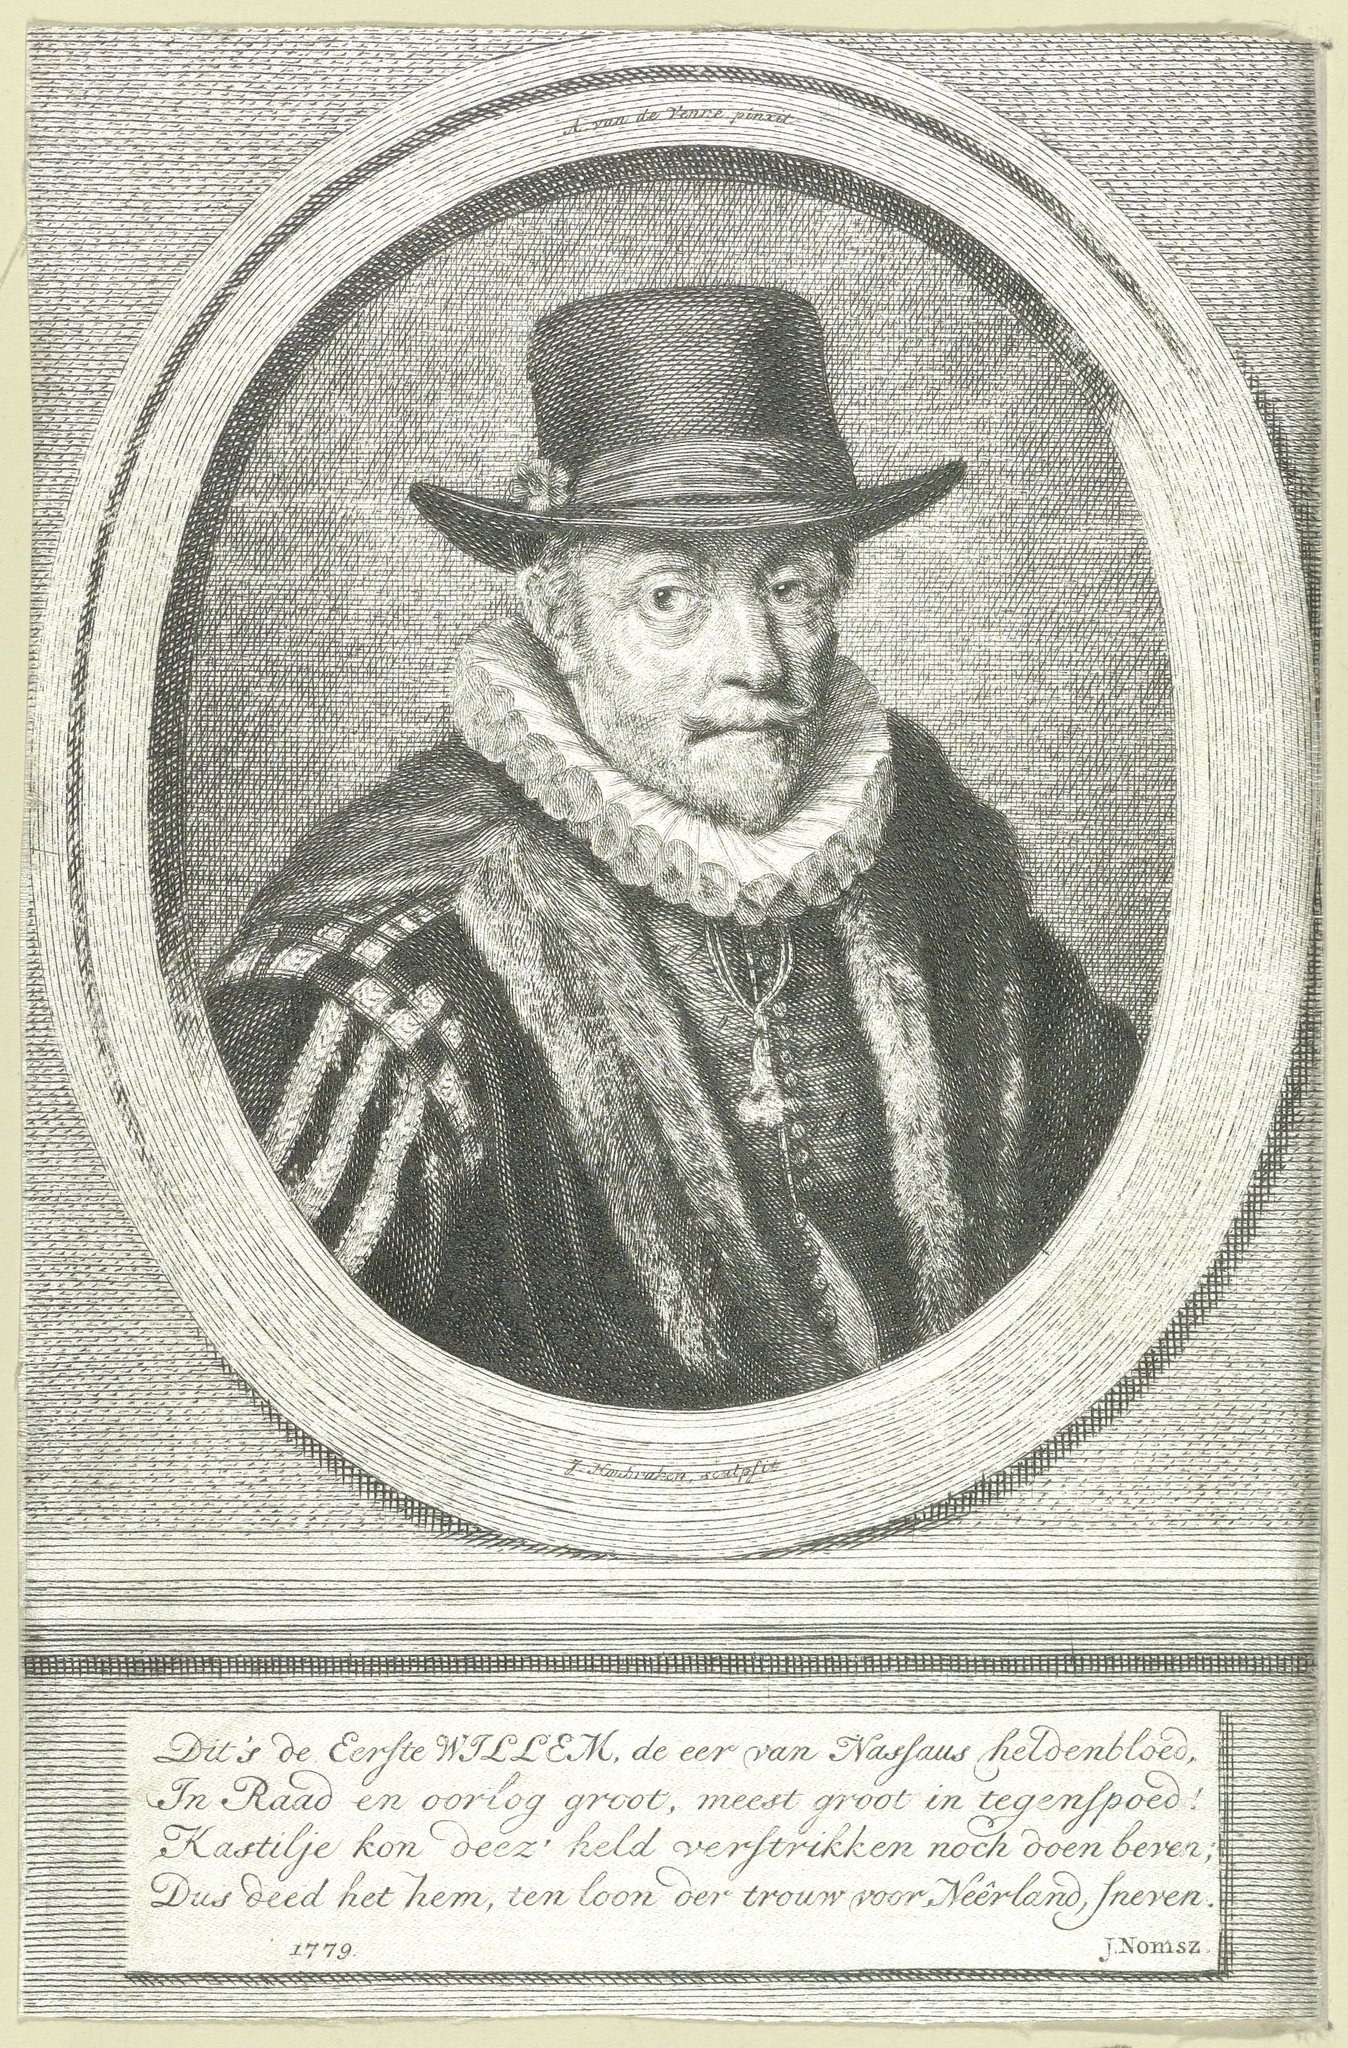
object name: print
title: Portret van Willem I, prins van Oranje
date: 1779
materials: textile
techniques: engraving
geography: amsterdam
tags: delft, william i (prince of orange)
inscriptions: collector's mark: Lugt 963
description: De hier vermelde titel verwijst naar de hoogst verkregen titel van de geportretteerde, niet per se naar de titel die de geportretteerde op deze voorstelling draagt.